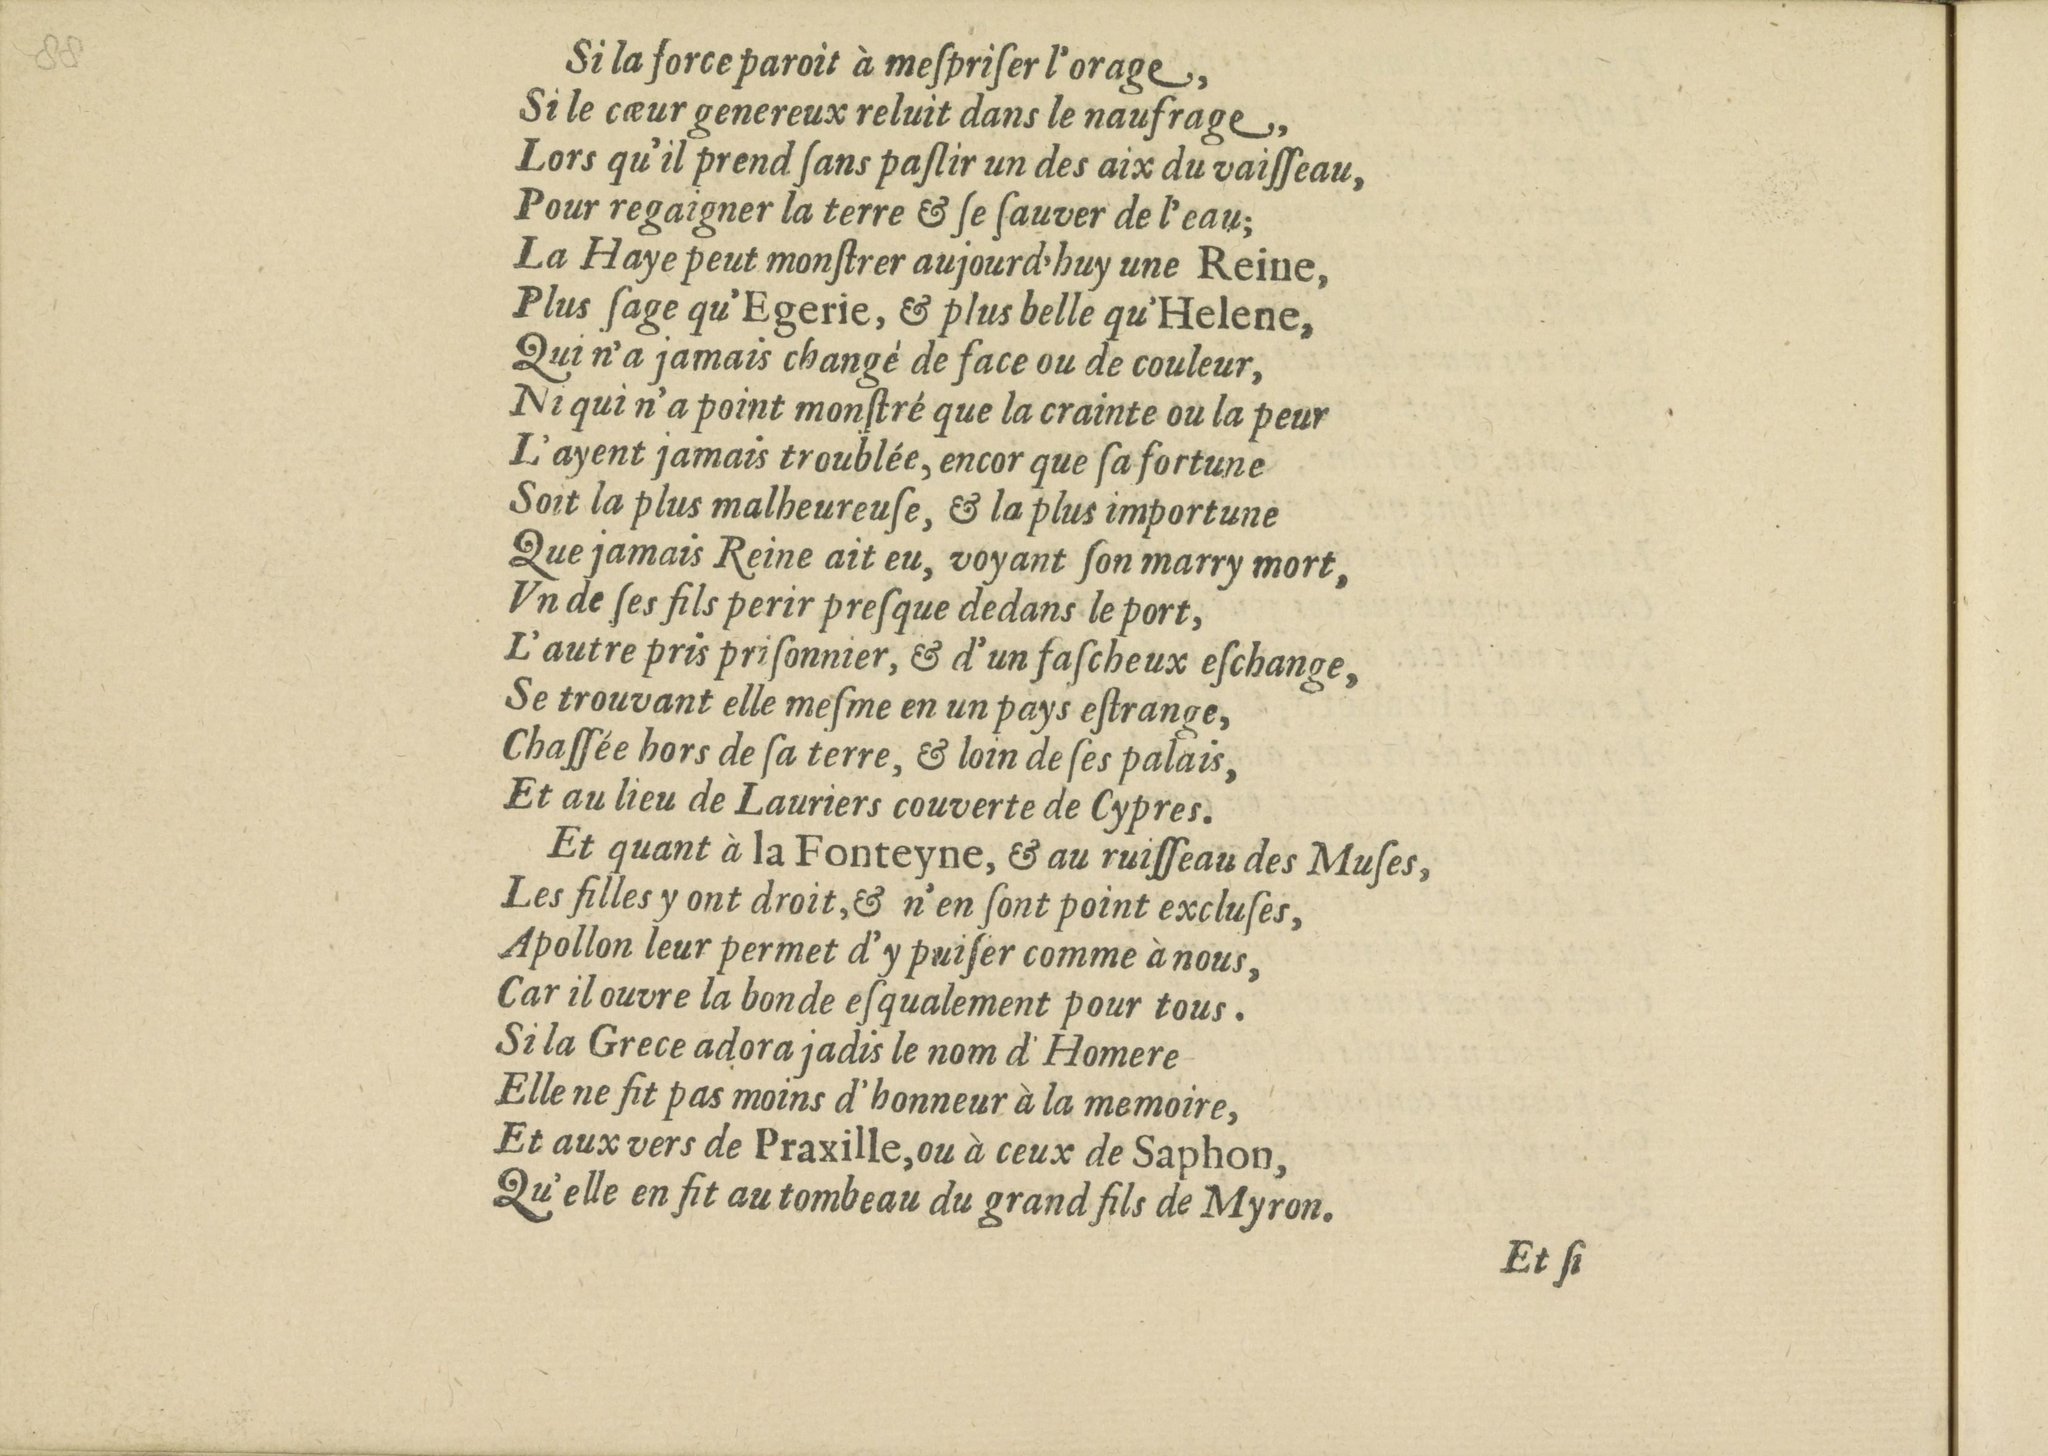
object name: album leaf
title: Les vrais pourtraits de quelques unes des plus grandes dames de la chrestiente desguisees en bergeres.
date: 1640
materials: paper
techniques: letterpress printing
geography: amsterdam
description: Franstalig gedicht op de Nimfen van de Amstel op zeven pagina's: pagina 4. Het blad maakt deel uit van een album.